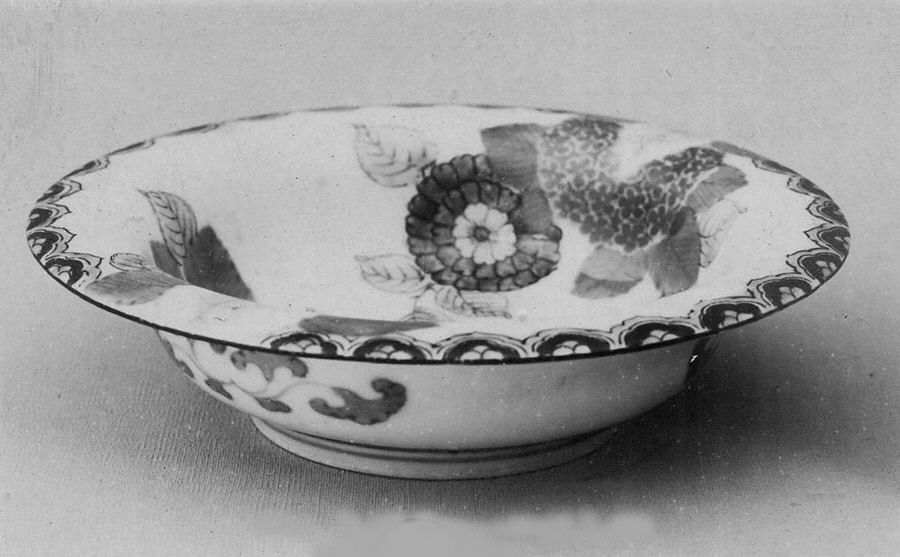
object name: dish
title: Small Dish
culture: japanese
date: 1750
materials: enamel, glaze, porcelain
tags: flowers